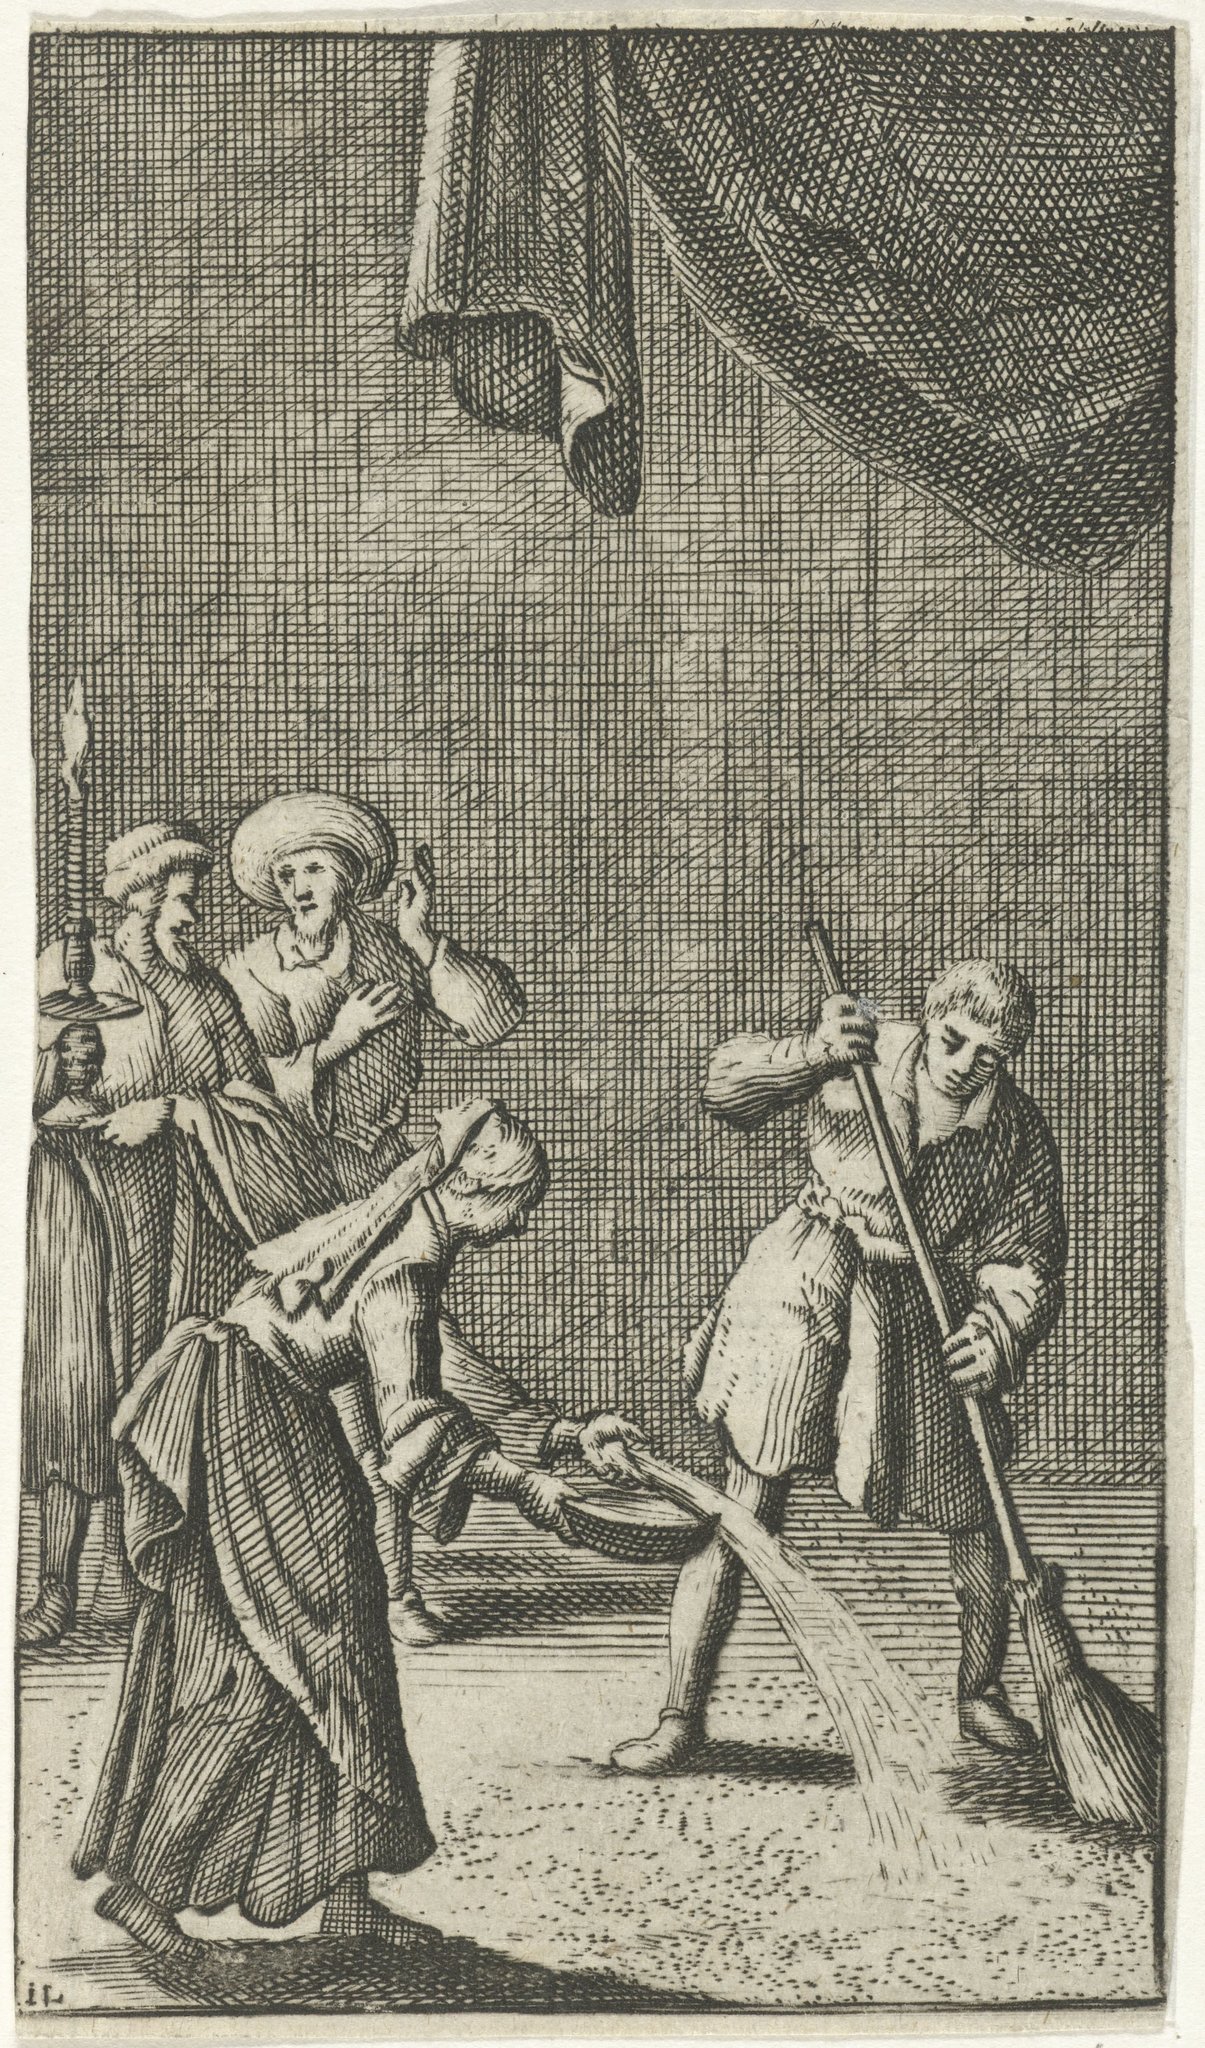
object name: print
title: Christen kijkt toe hoe een man en vrouw de vloer schoonmaken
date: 1687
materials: paper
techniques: etching, letterpress printing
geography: amsterdam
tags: cleaning (the house)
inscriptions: collector's mark: Lugt 2228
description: Illustratie opgenomen in: Bunyan, John. Eens christens reyse na de eeuwigheyt. Amsterdam: Johannes Boekholt, 1687. Dit is de vijfde druk met sterk opgesneden platen.